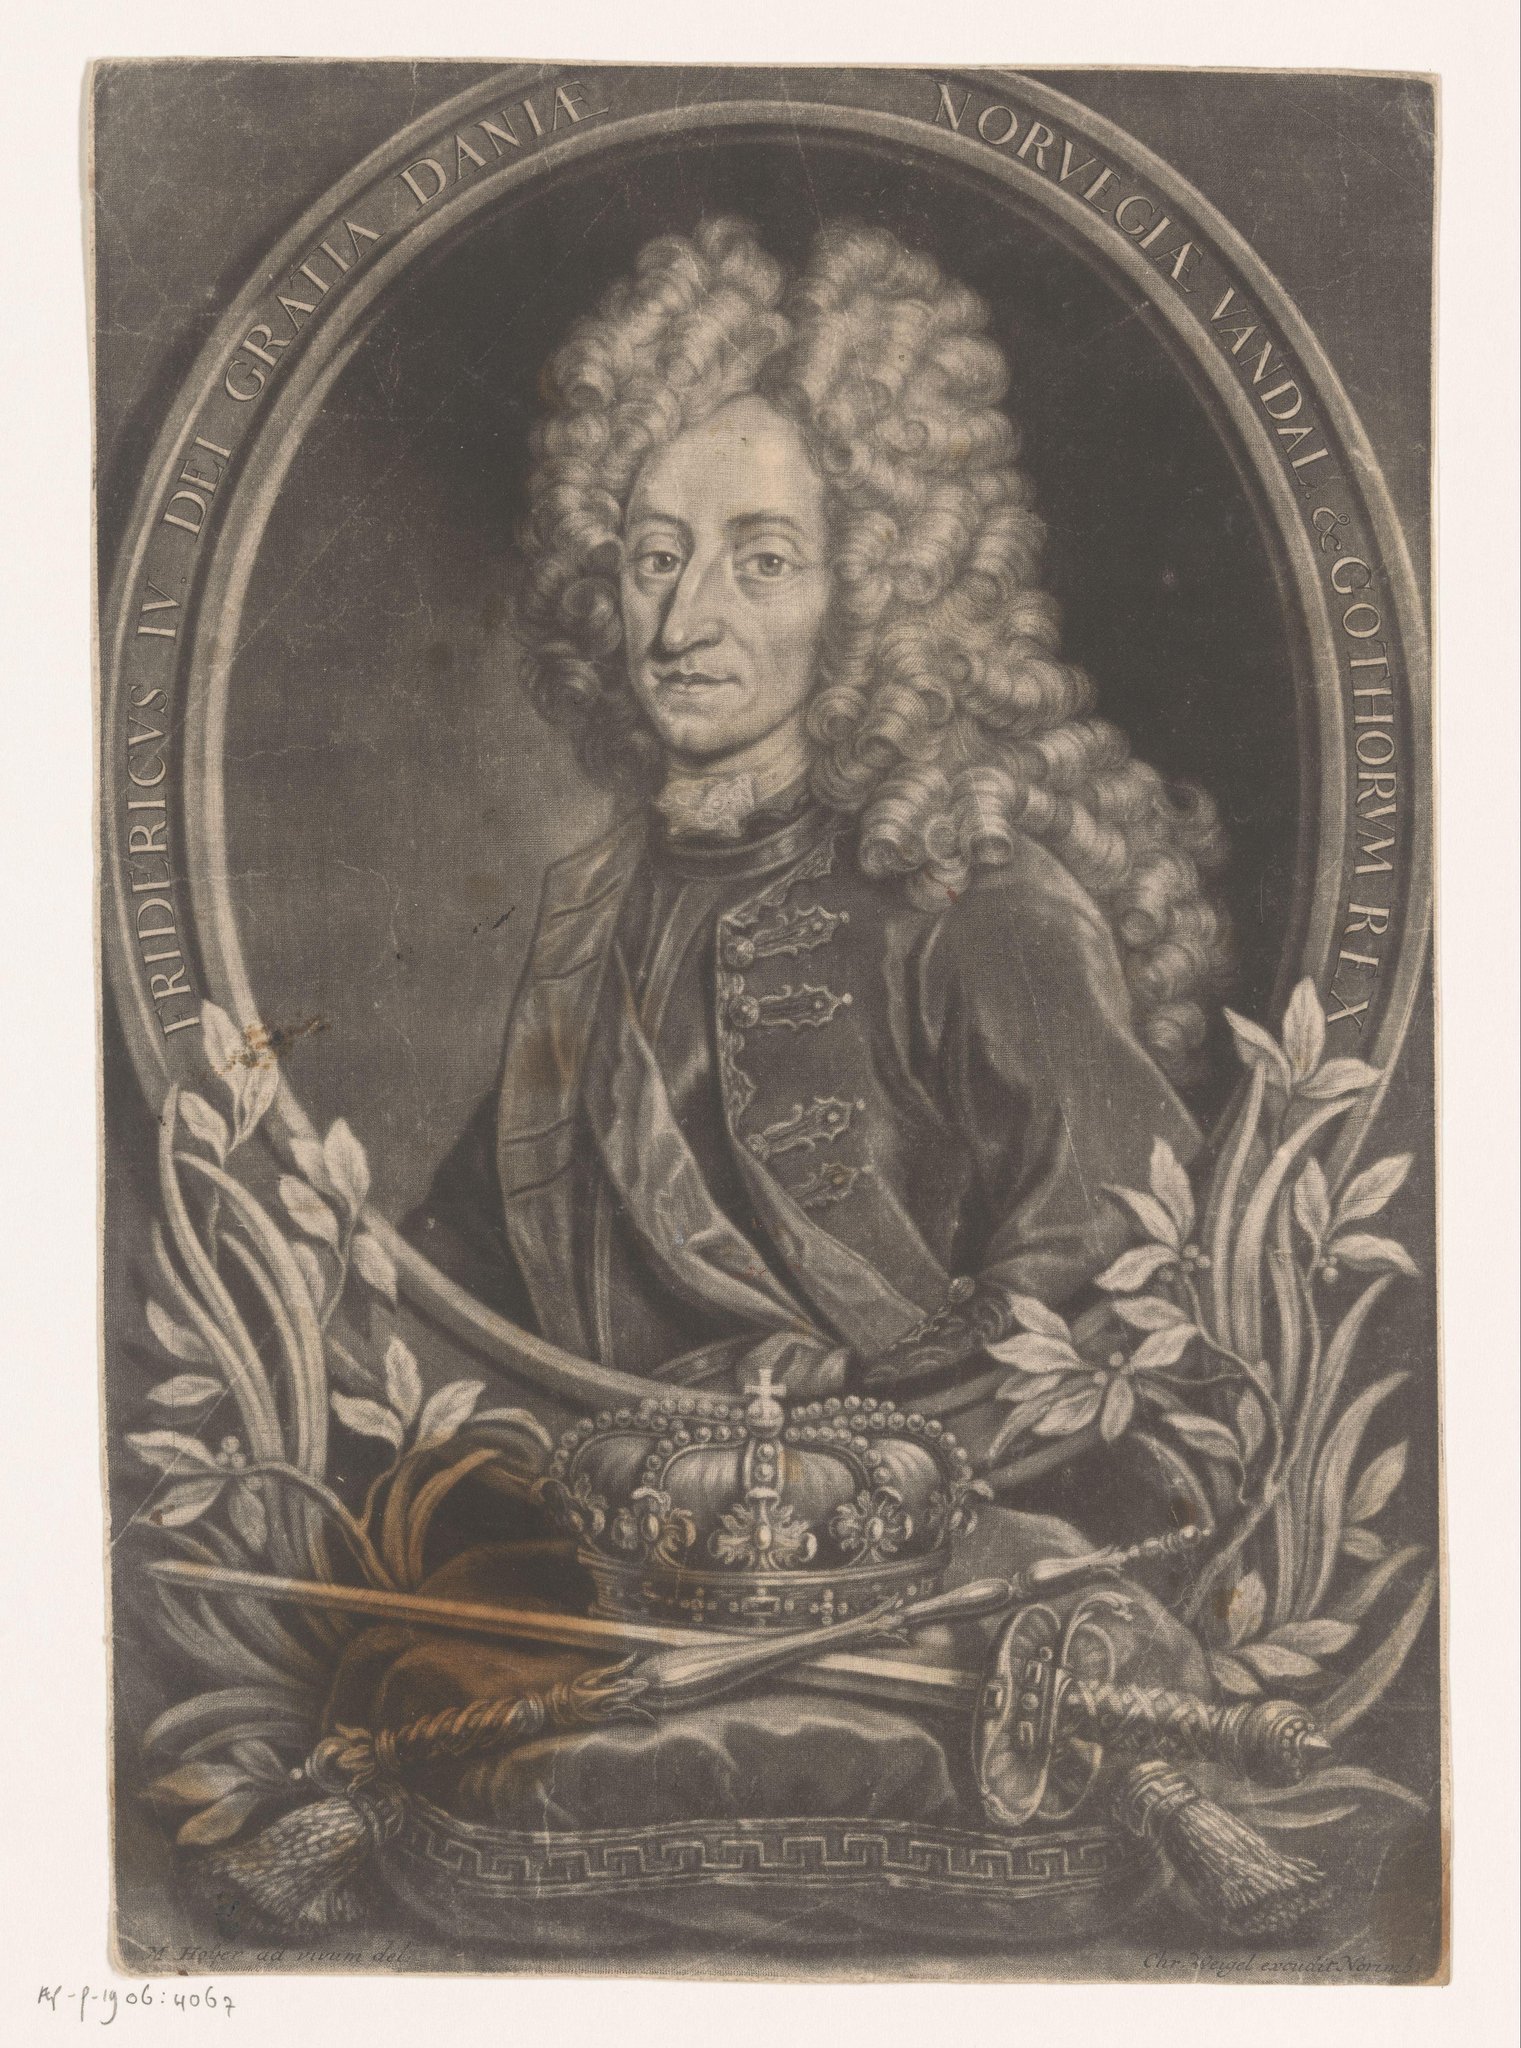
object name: print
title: Portret van Frederik IV, koning van Denemarken en Noorwegen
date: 1699-1725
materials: paper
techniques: mezzotint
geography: nuremberg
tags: copenhagen (city), frederik iv (koning van denemarken en noorwegen), historical persons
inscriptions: collector's mark: Lugt 2228